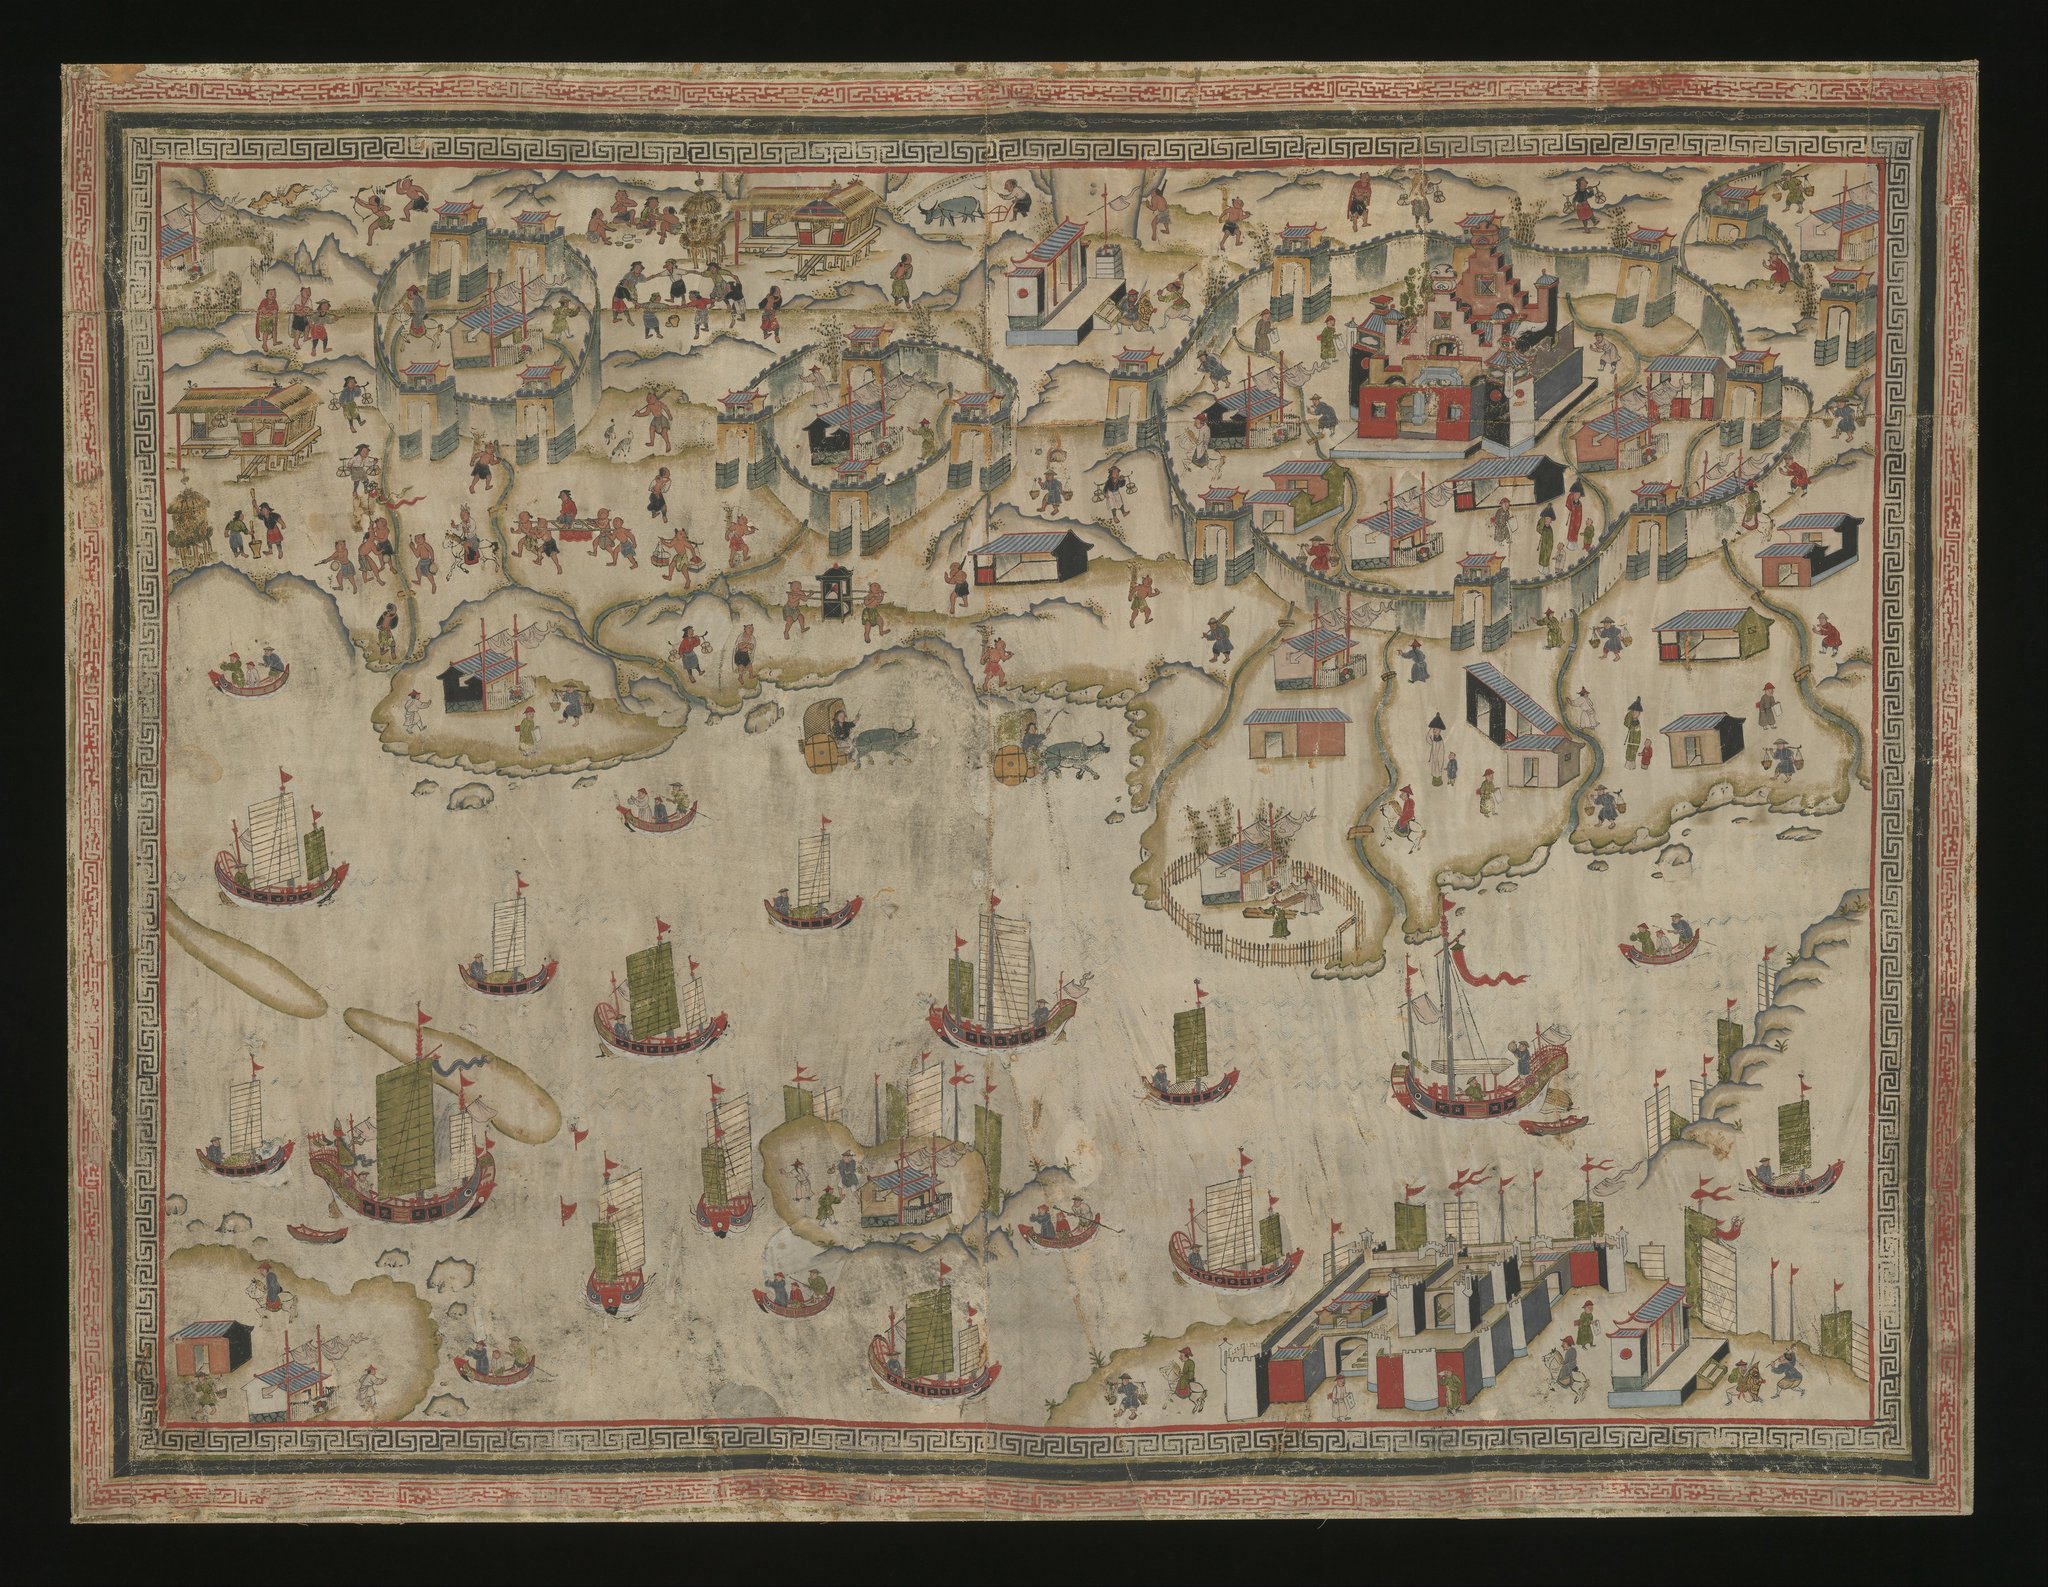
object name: pictorial map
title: Forts Zeelandia and Provintia and the City of Tainan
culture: chinese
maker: unidentified artist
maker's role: artist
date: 1801-1900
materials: ink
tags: houses,cities,boats,ships,maps